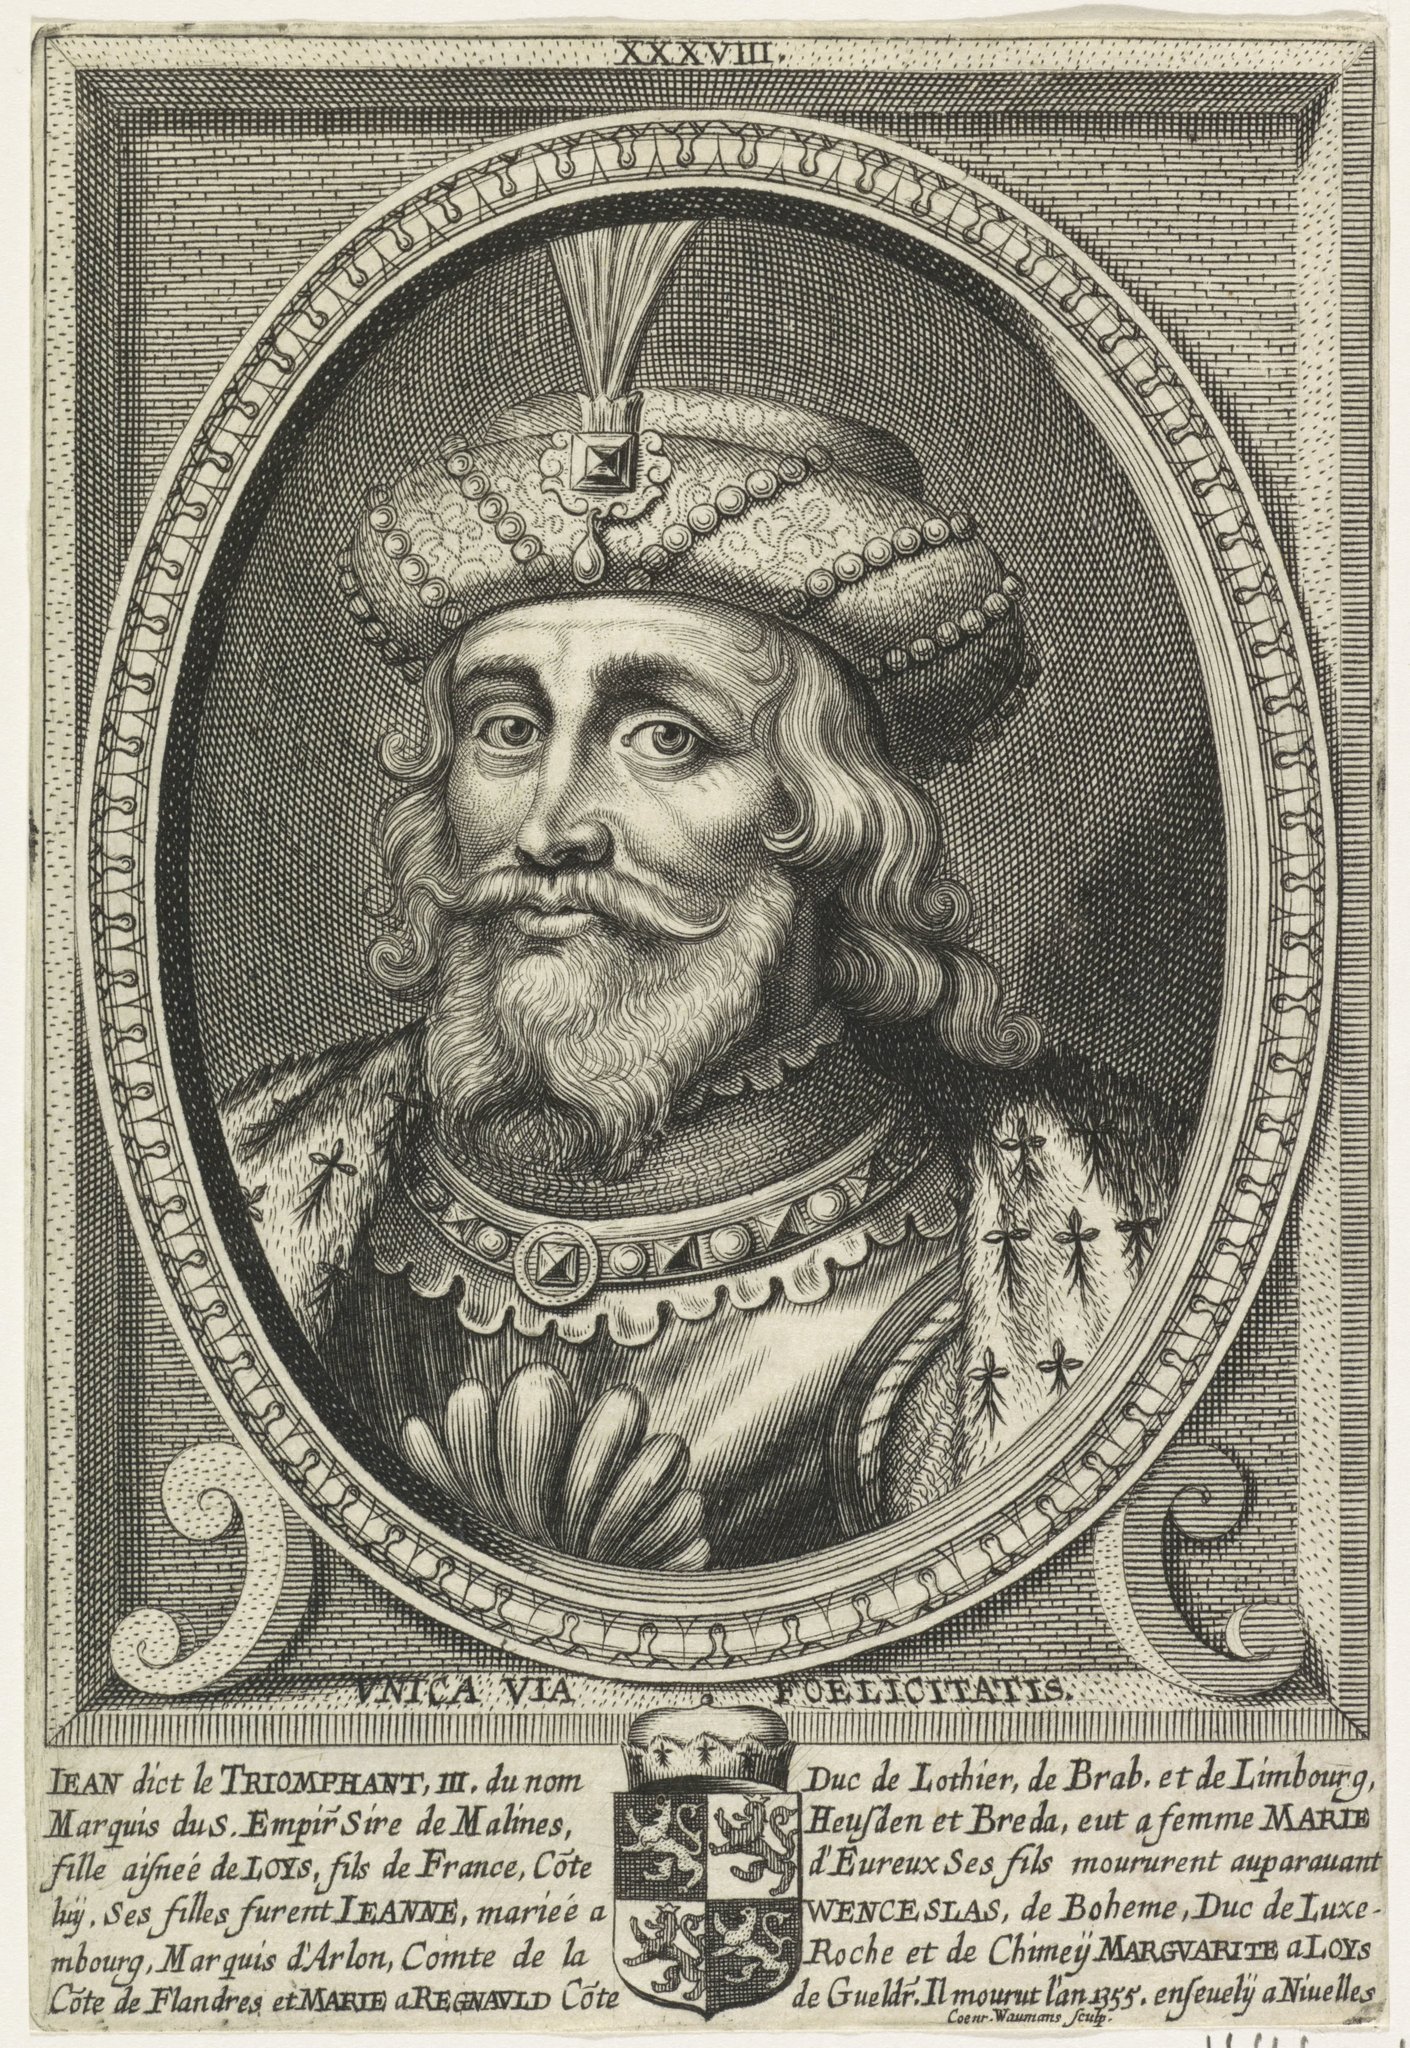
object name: print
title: Portret van Jan III, hertog van Brabant en Lotharingen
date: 1662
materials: paper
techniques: engraving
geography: antwerp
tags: brussels, armorial bearing, heraldry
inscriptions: collector's mark: Lugt 240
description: Prent gebruikt in: Meyssens, C. Les pourtraits des souverains princes et comtes de Hollande. Antwerpen: J. Meyssens, 1662. Op de frontispiece wordt Richard Collin specifiek genoemd als graveur van de wapenschilden op de prenten in deze uitgave.